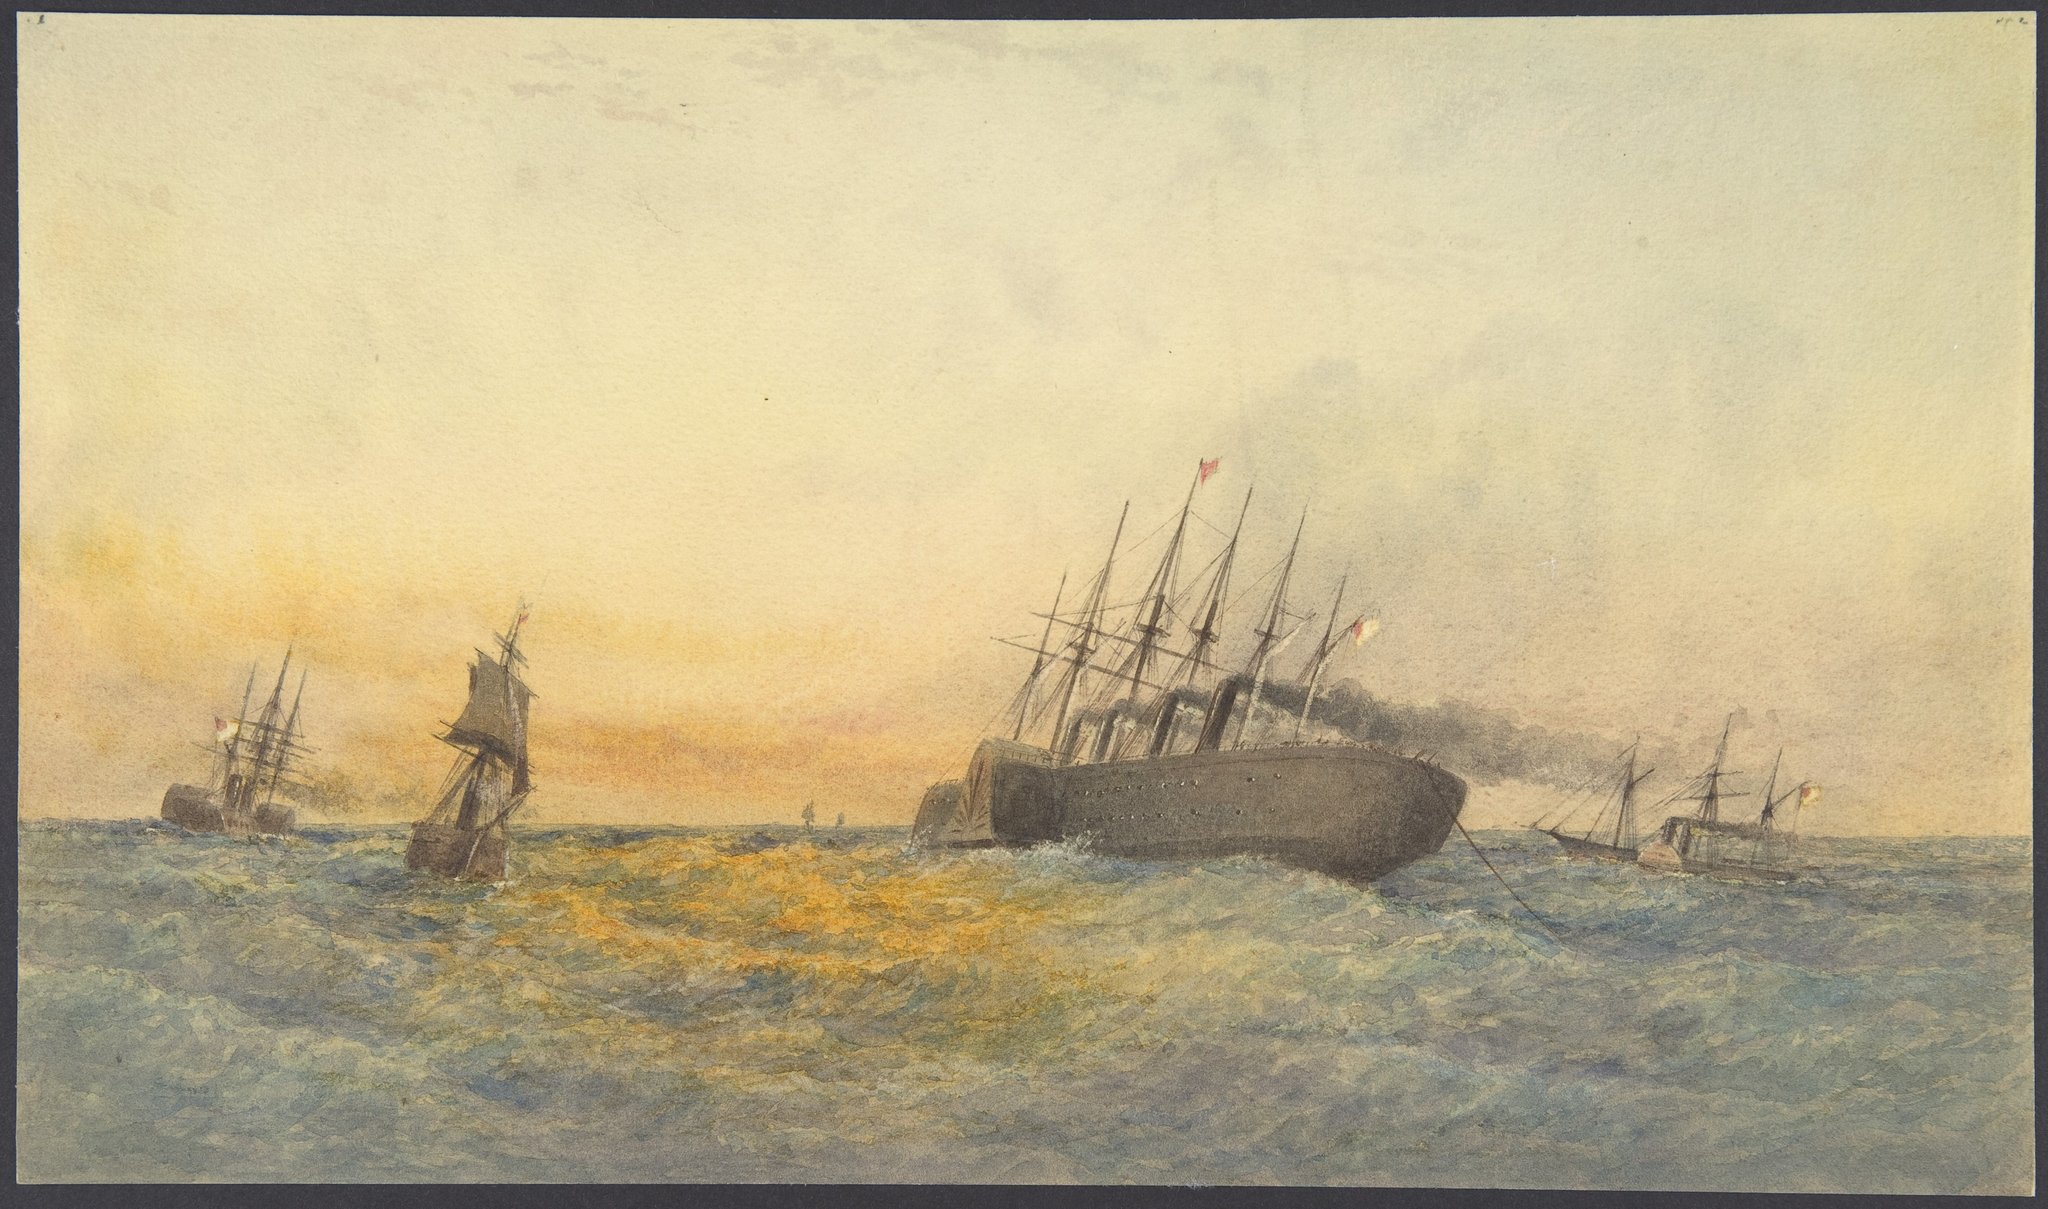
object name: drawing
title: The Great Eastern Under Weigh, July 23rd, 1865: Escort and other Ships, H.M.S. Terrible, H.M.S. Sphinx, The Hawk and Revised: The Caroline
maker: robert charles dudley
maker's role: artist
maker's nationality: british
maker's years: 1826-1909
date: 1865-1866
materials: gouache, graphite, watercolor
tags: ships,transatlantic cable